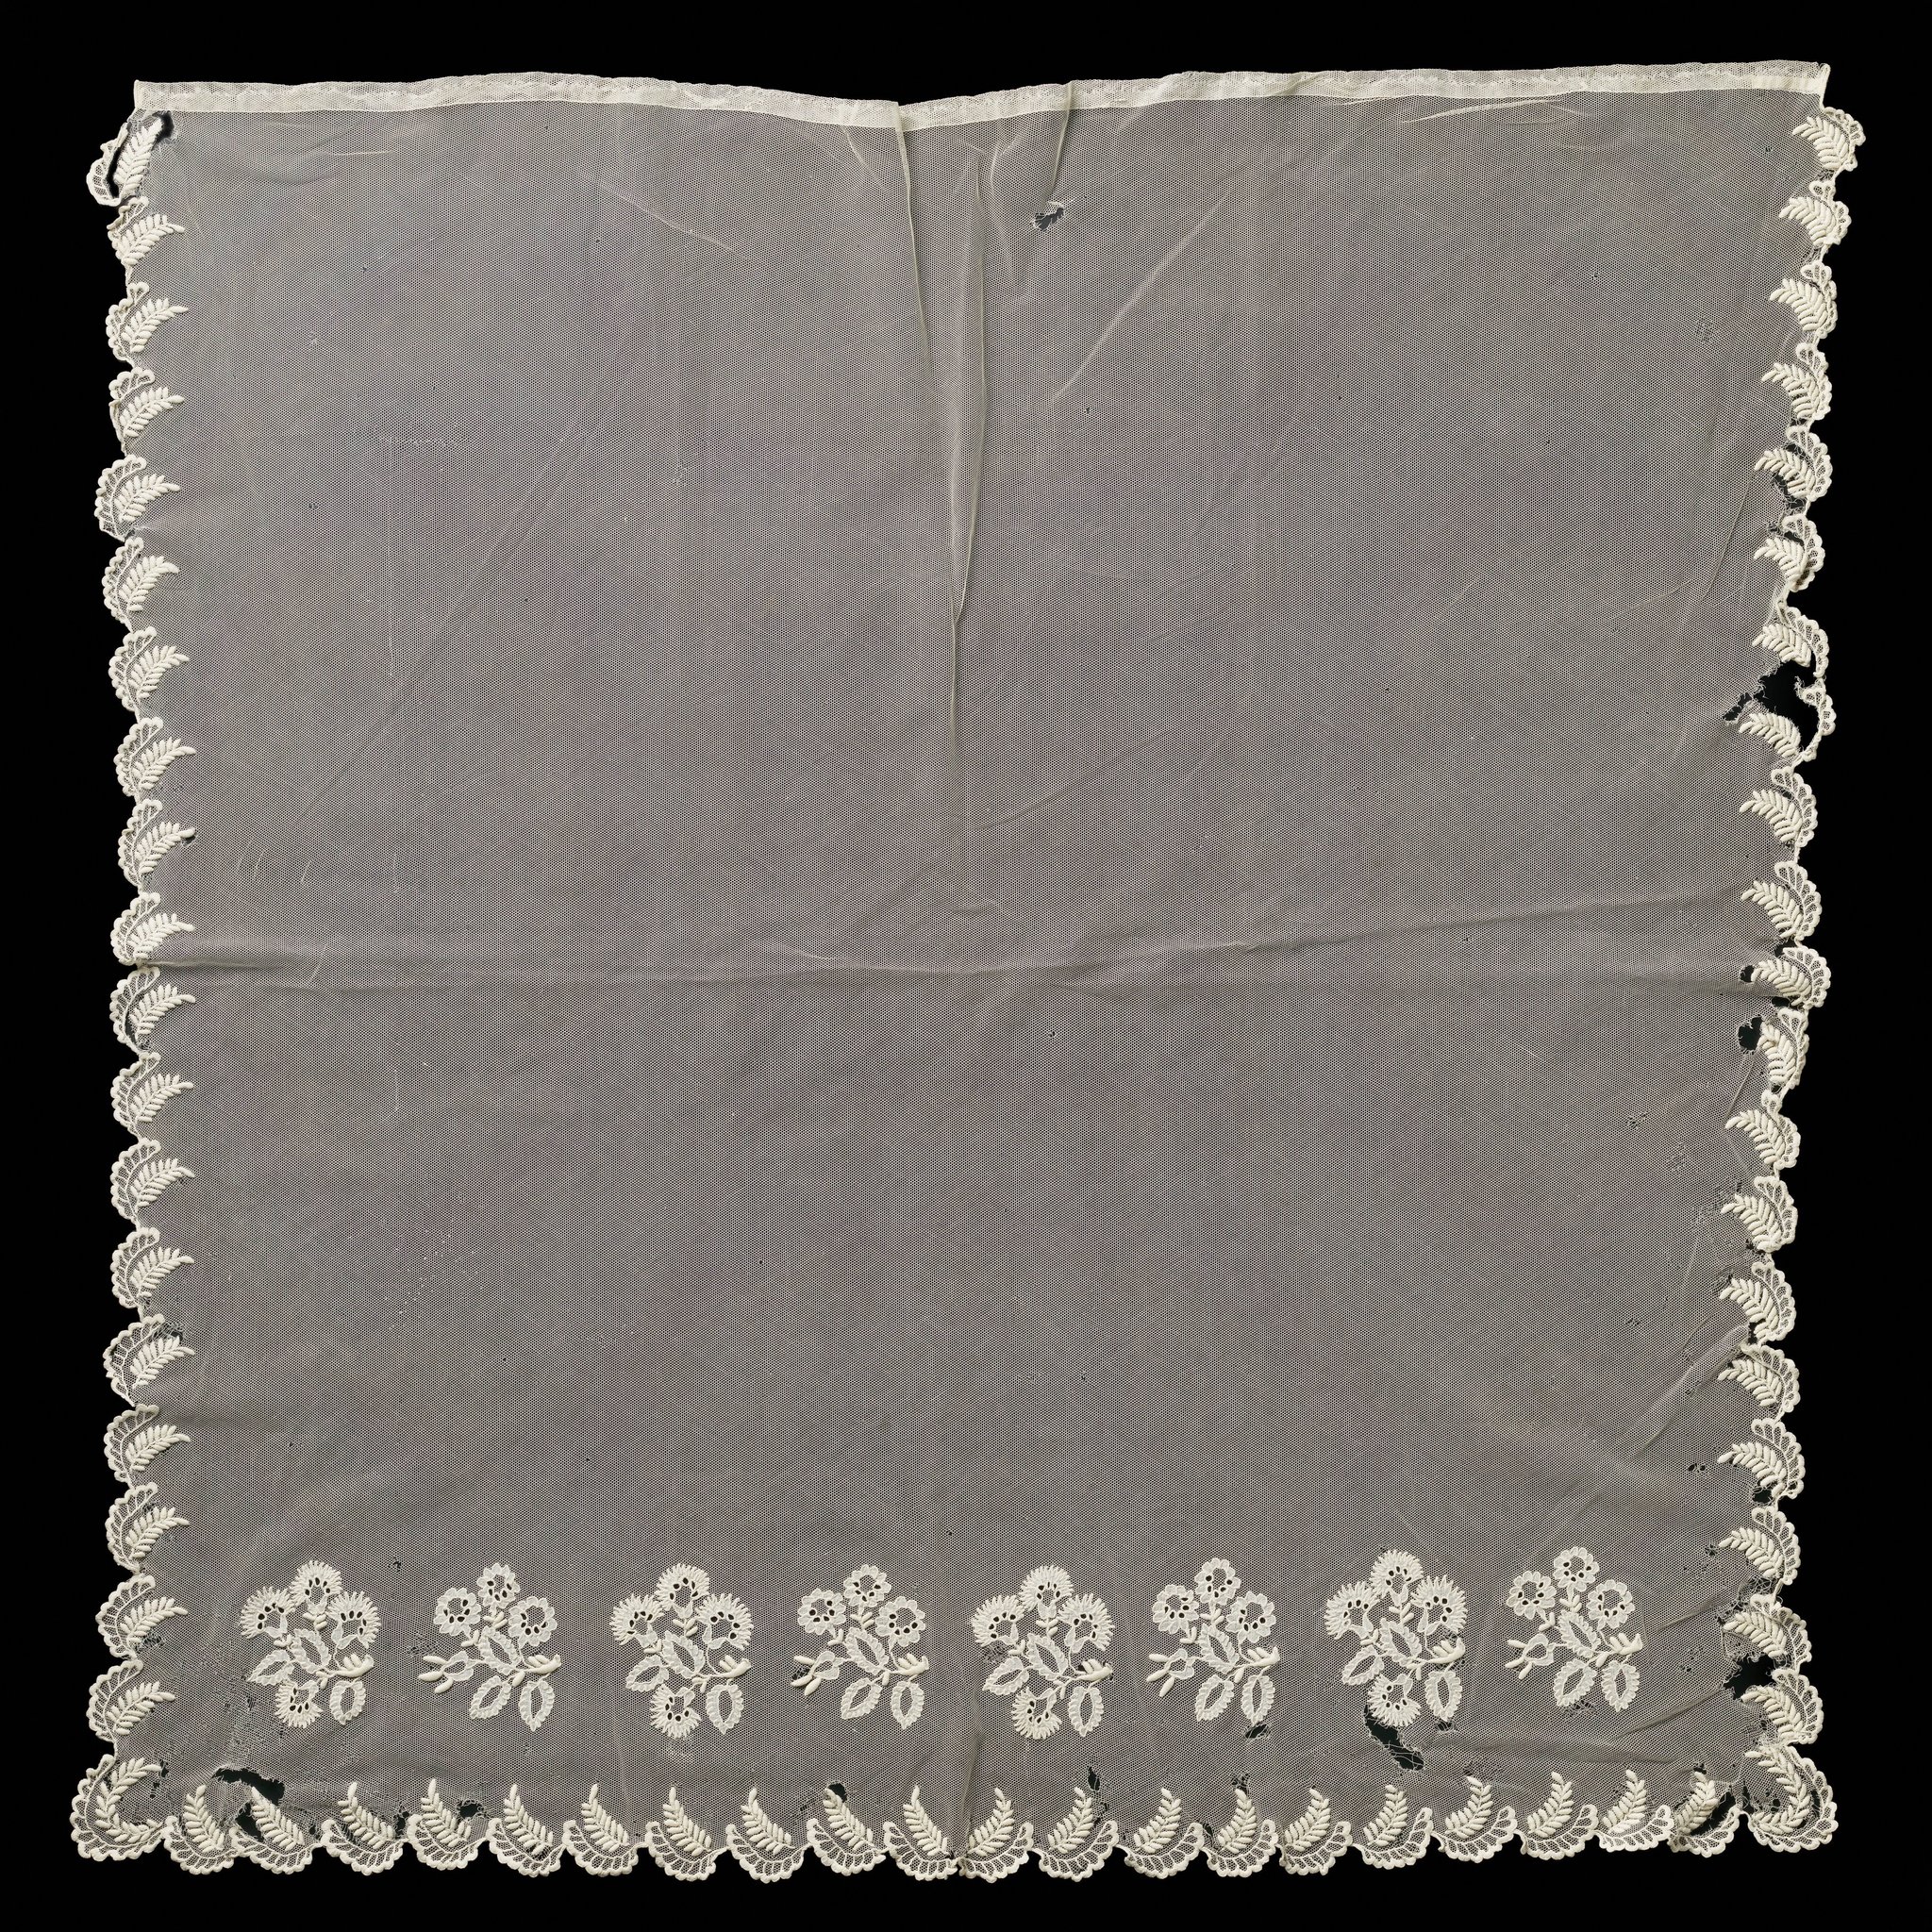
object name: doopkleed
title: Doopkleed van kantborduurwerk op machinale tule met plumetis en geappliceerde boeketten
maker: Anonymous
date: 1825-1830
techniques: embroidered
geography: netherlands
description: Doopkleed van naturelkleurig kantborduurwerk van plumetis op machinale tule. Drie zijden hebben een geborduurde schulprand, met in elke schulp een gevederd bladmotief. De onderrand heeft bovendien nog acht geappliceerde bloemboeketten van fijn linnen gecombineerd met plumetis. De bovenrand is afgewerkt met een zoompje.